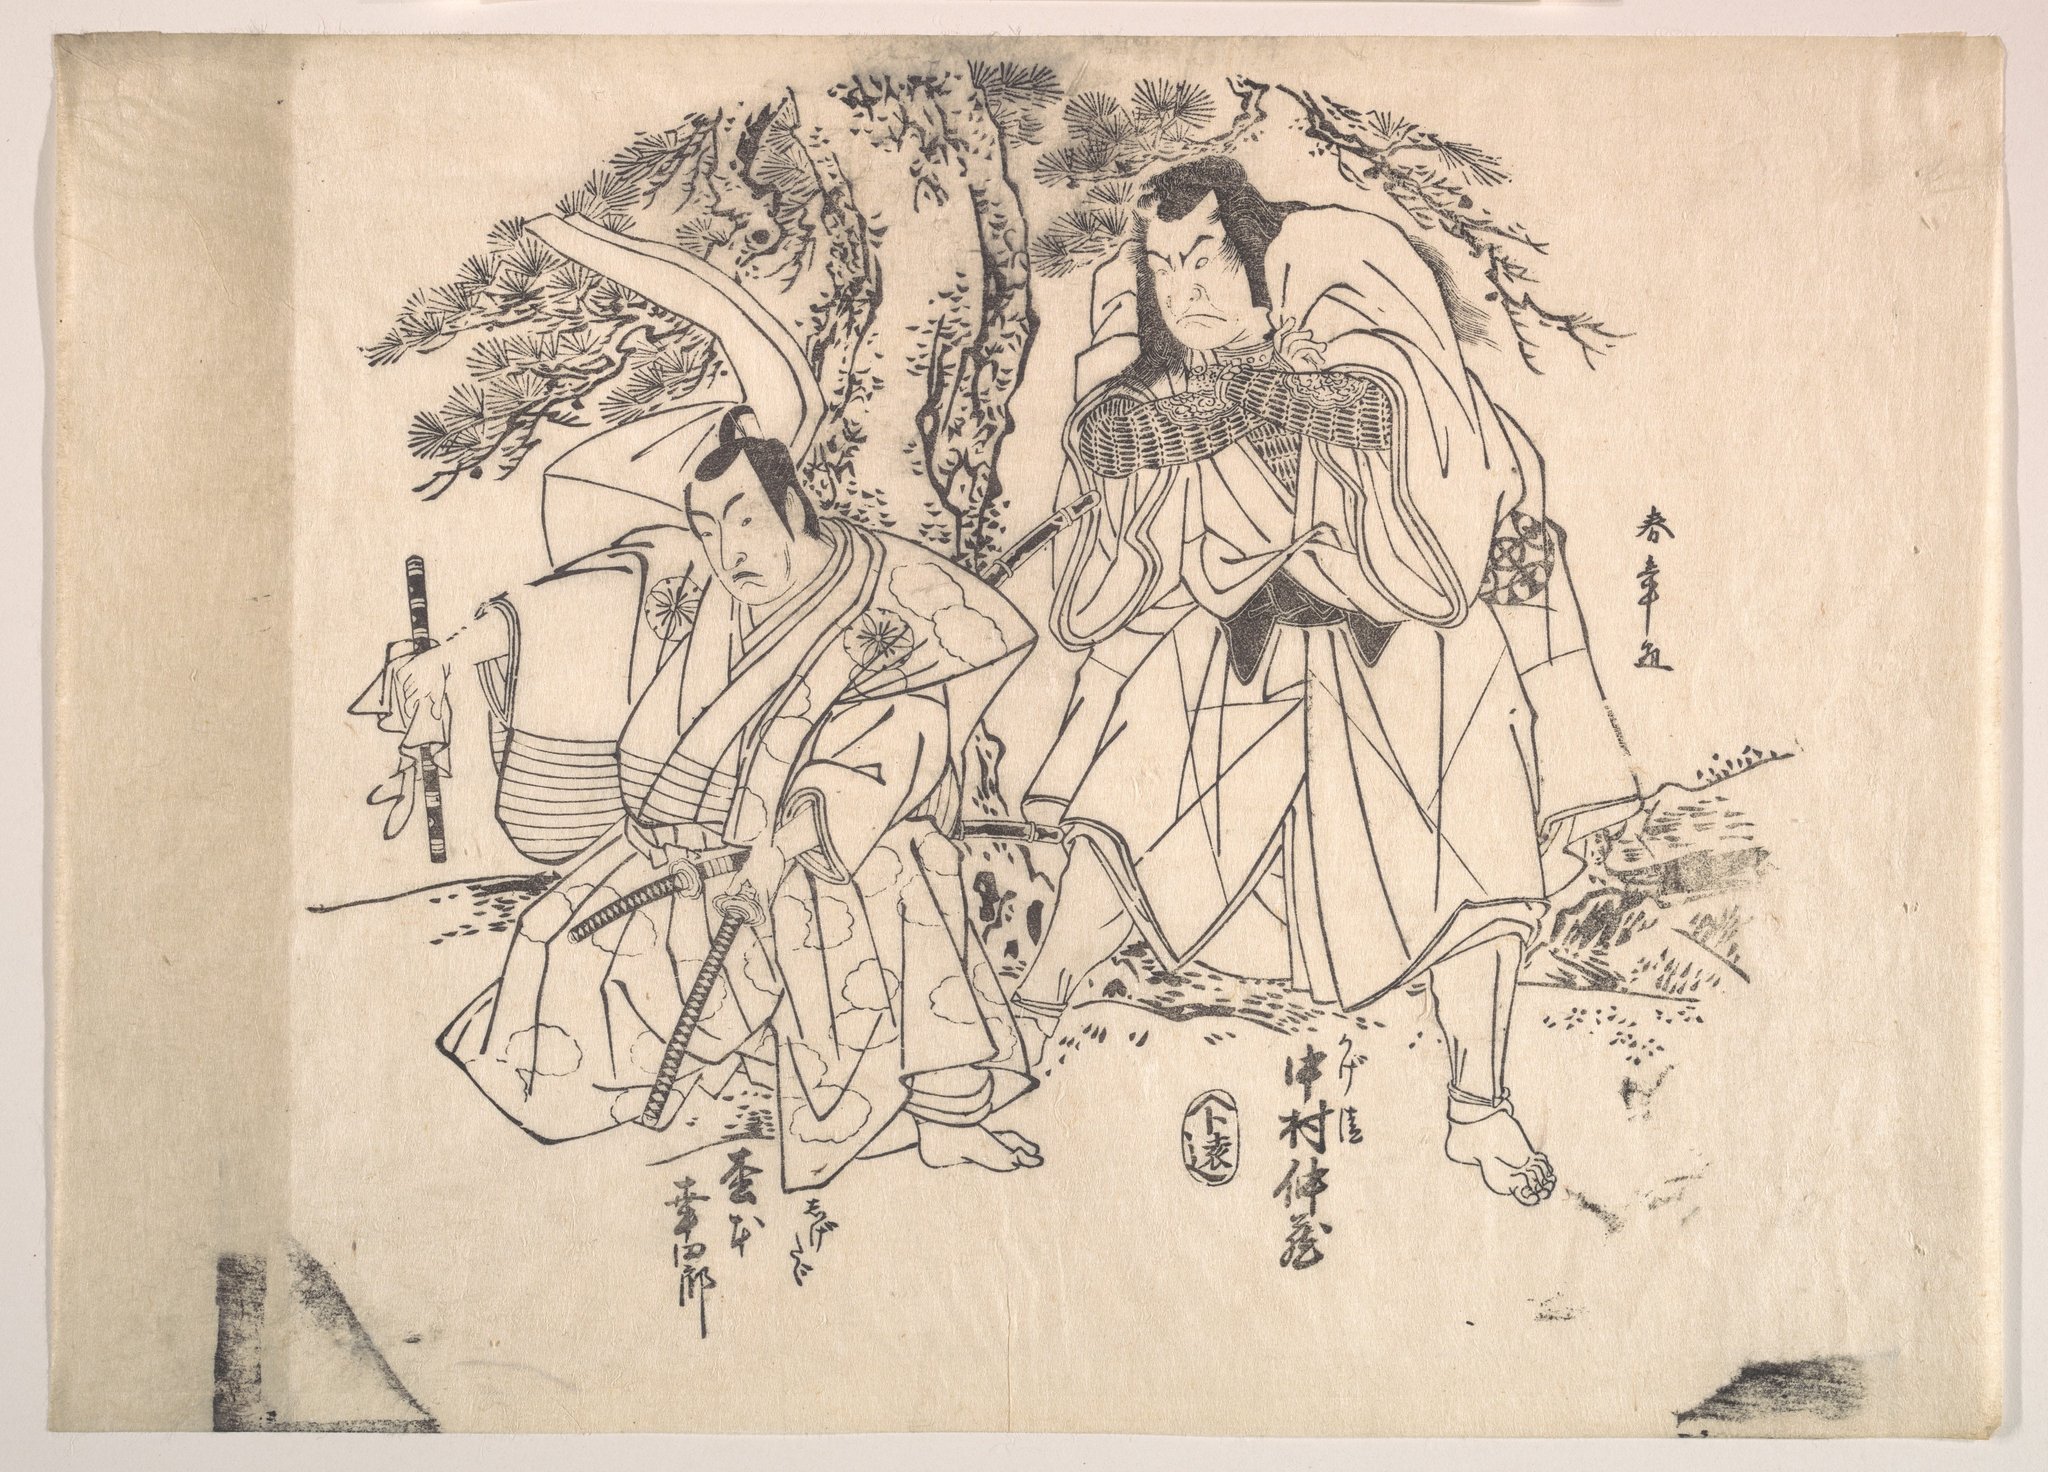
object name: design for a fan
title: Scene from a Play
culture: japanese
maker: katsukawa shunshō 勝川春章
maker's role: artist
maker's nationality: japanese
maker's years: 1726-1792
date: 1726-1792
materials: ink, paper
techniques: woodblock print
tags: men,trees,actors